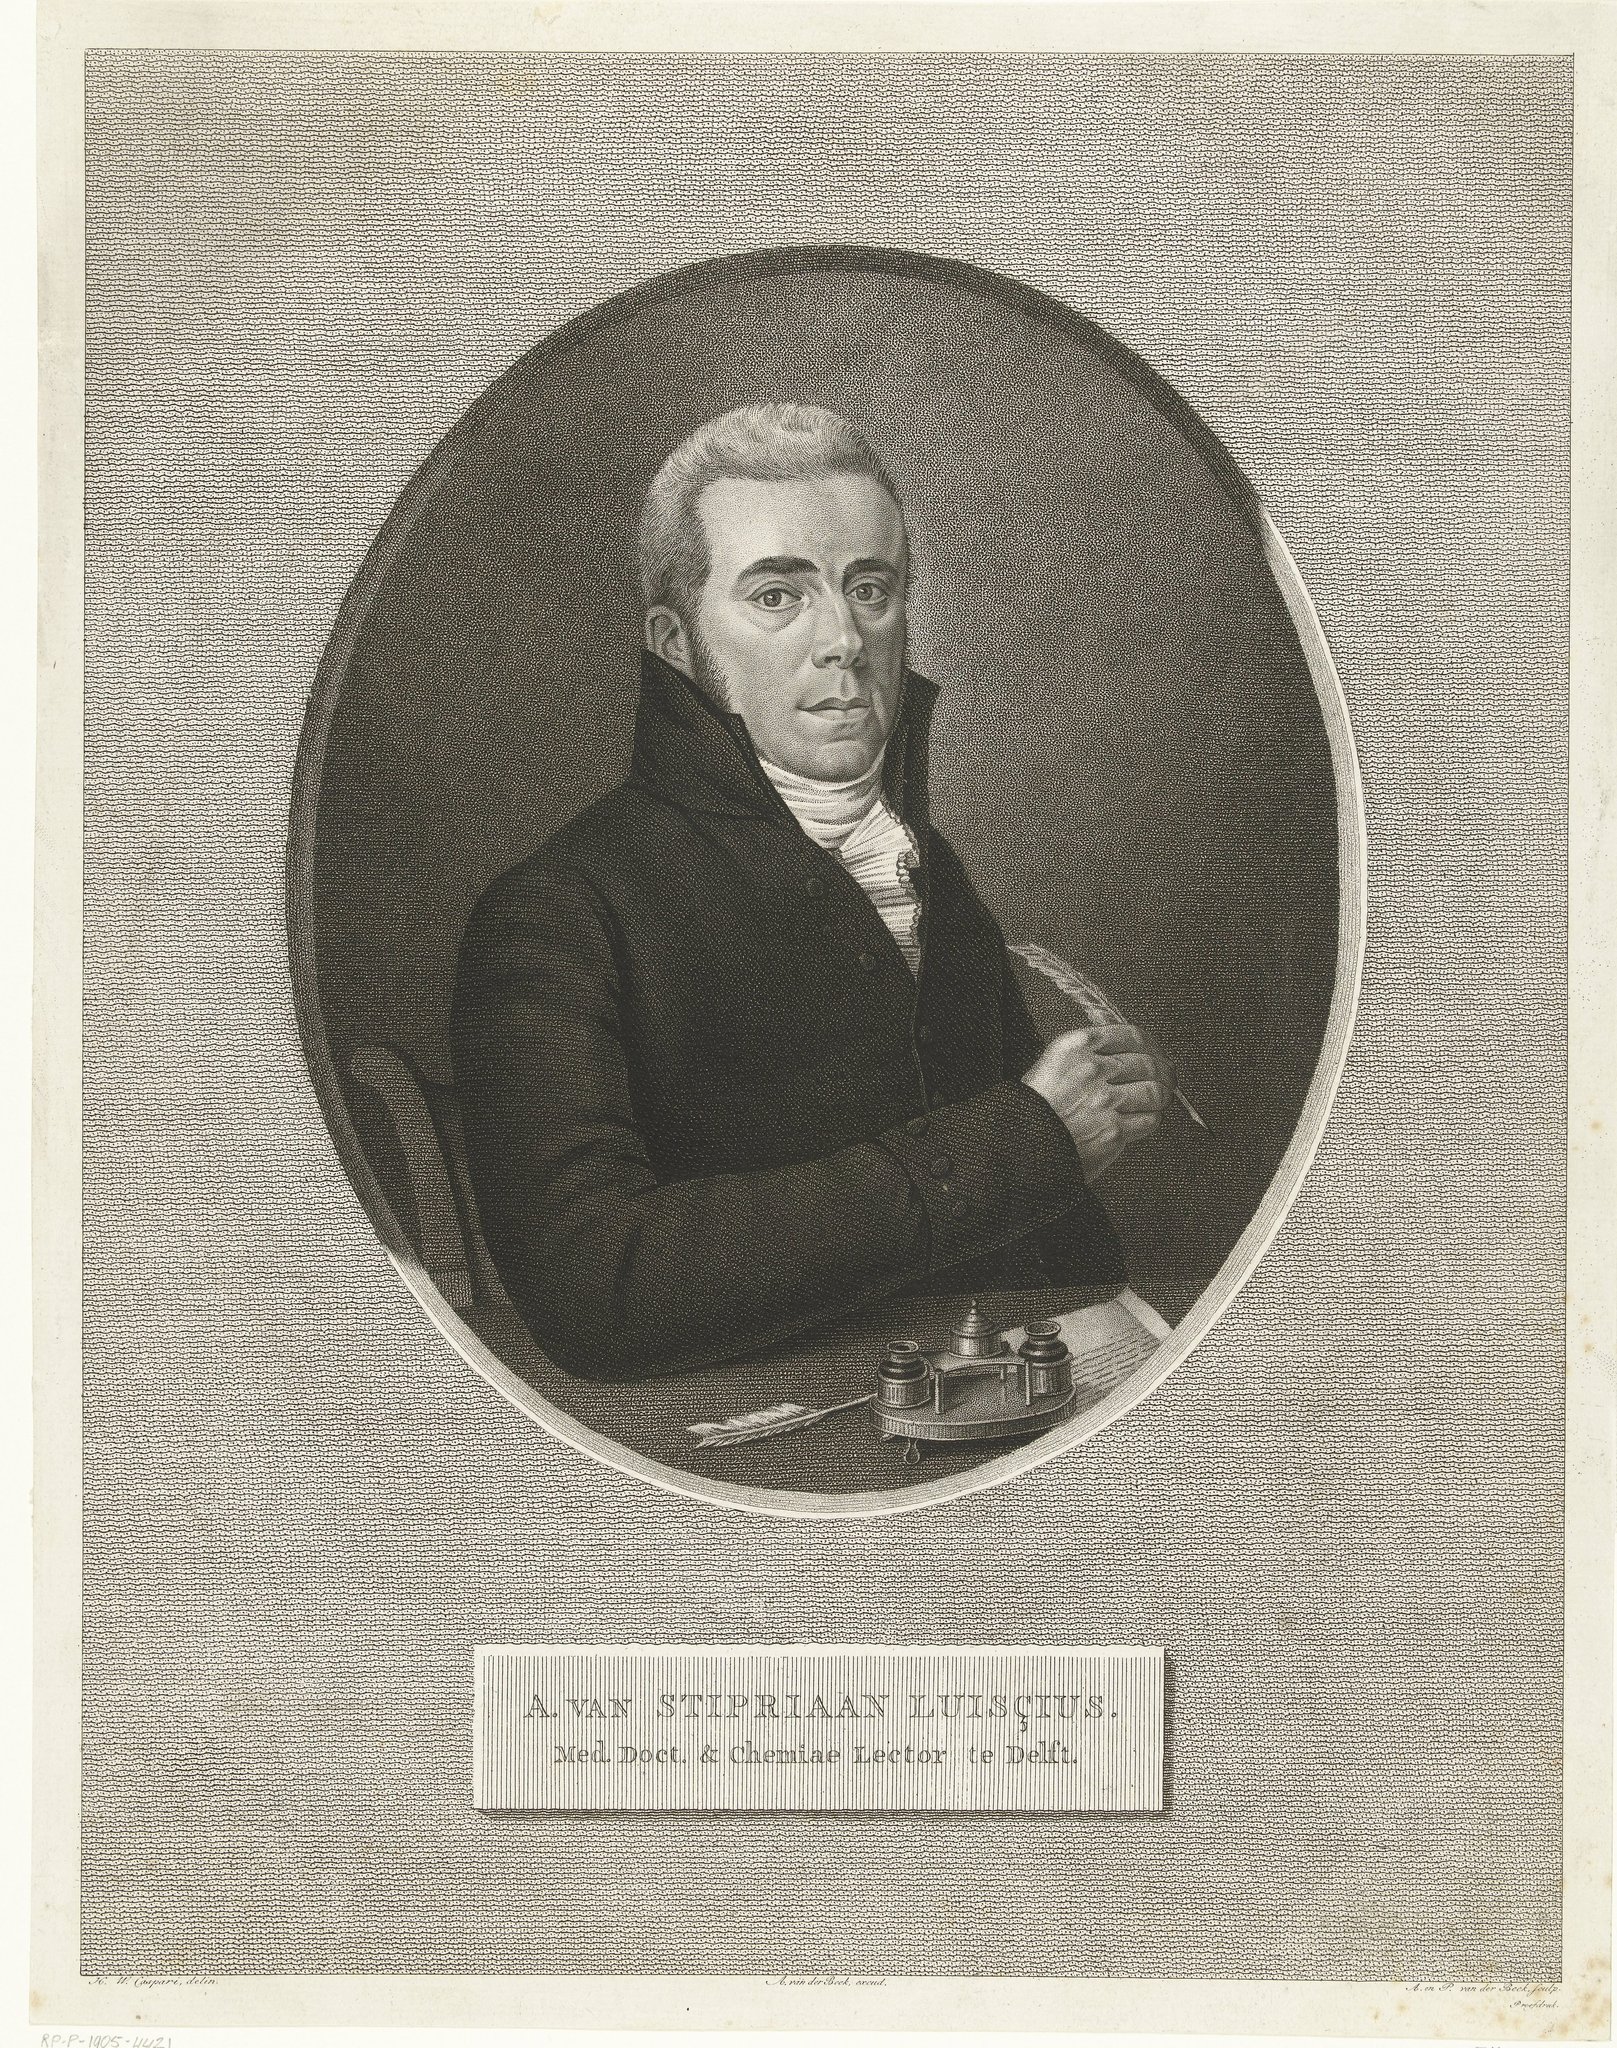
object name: print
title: A. van Stipriaan Luisçius Med. Doct. & Chemiae Lector te Delft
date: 1795-1852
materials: paper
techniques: aquatint, etching, roulette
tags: scholastic education, tuition (+ teacher, professor)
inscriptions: collector's mark: Lugt 2228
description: Prent naar tekening van hendrik Willem Caspari.